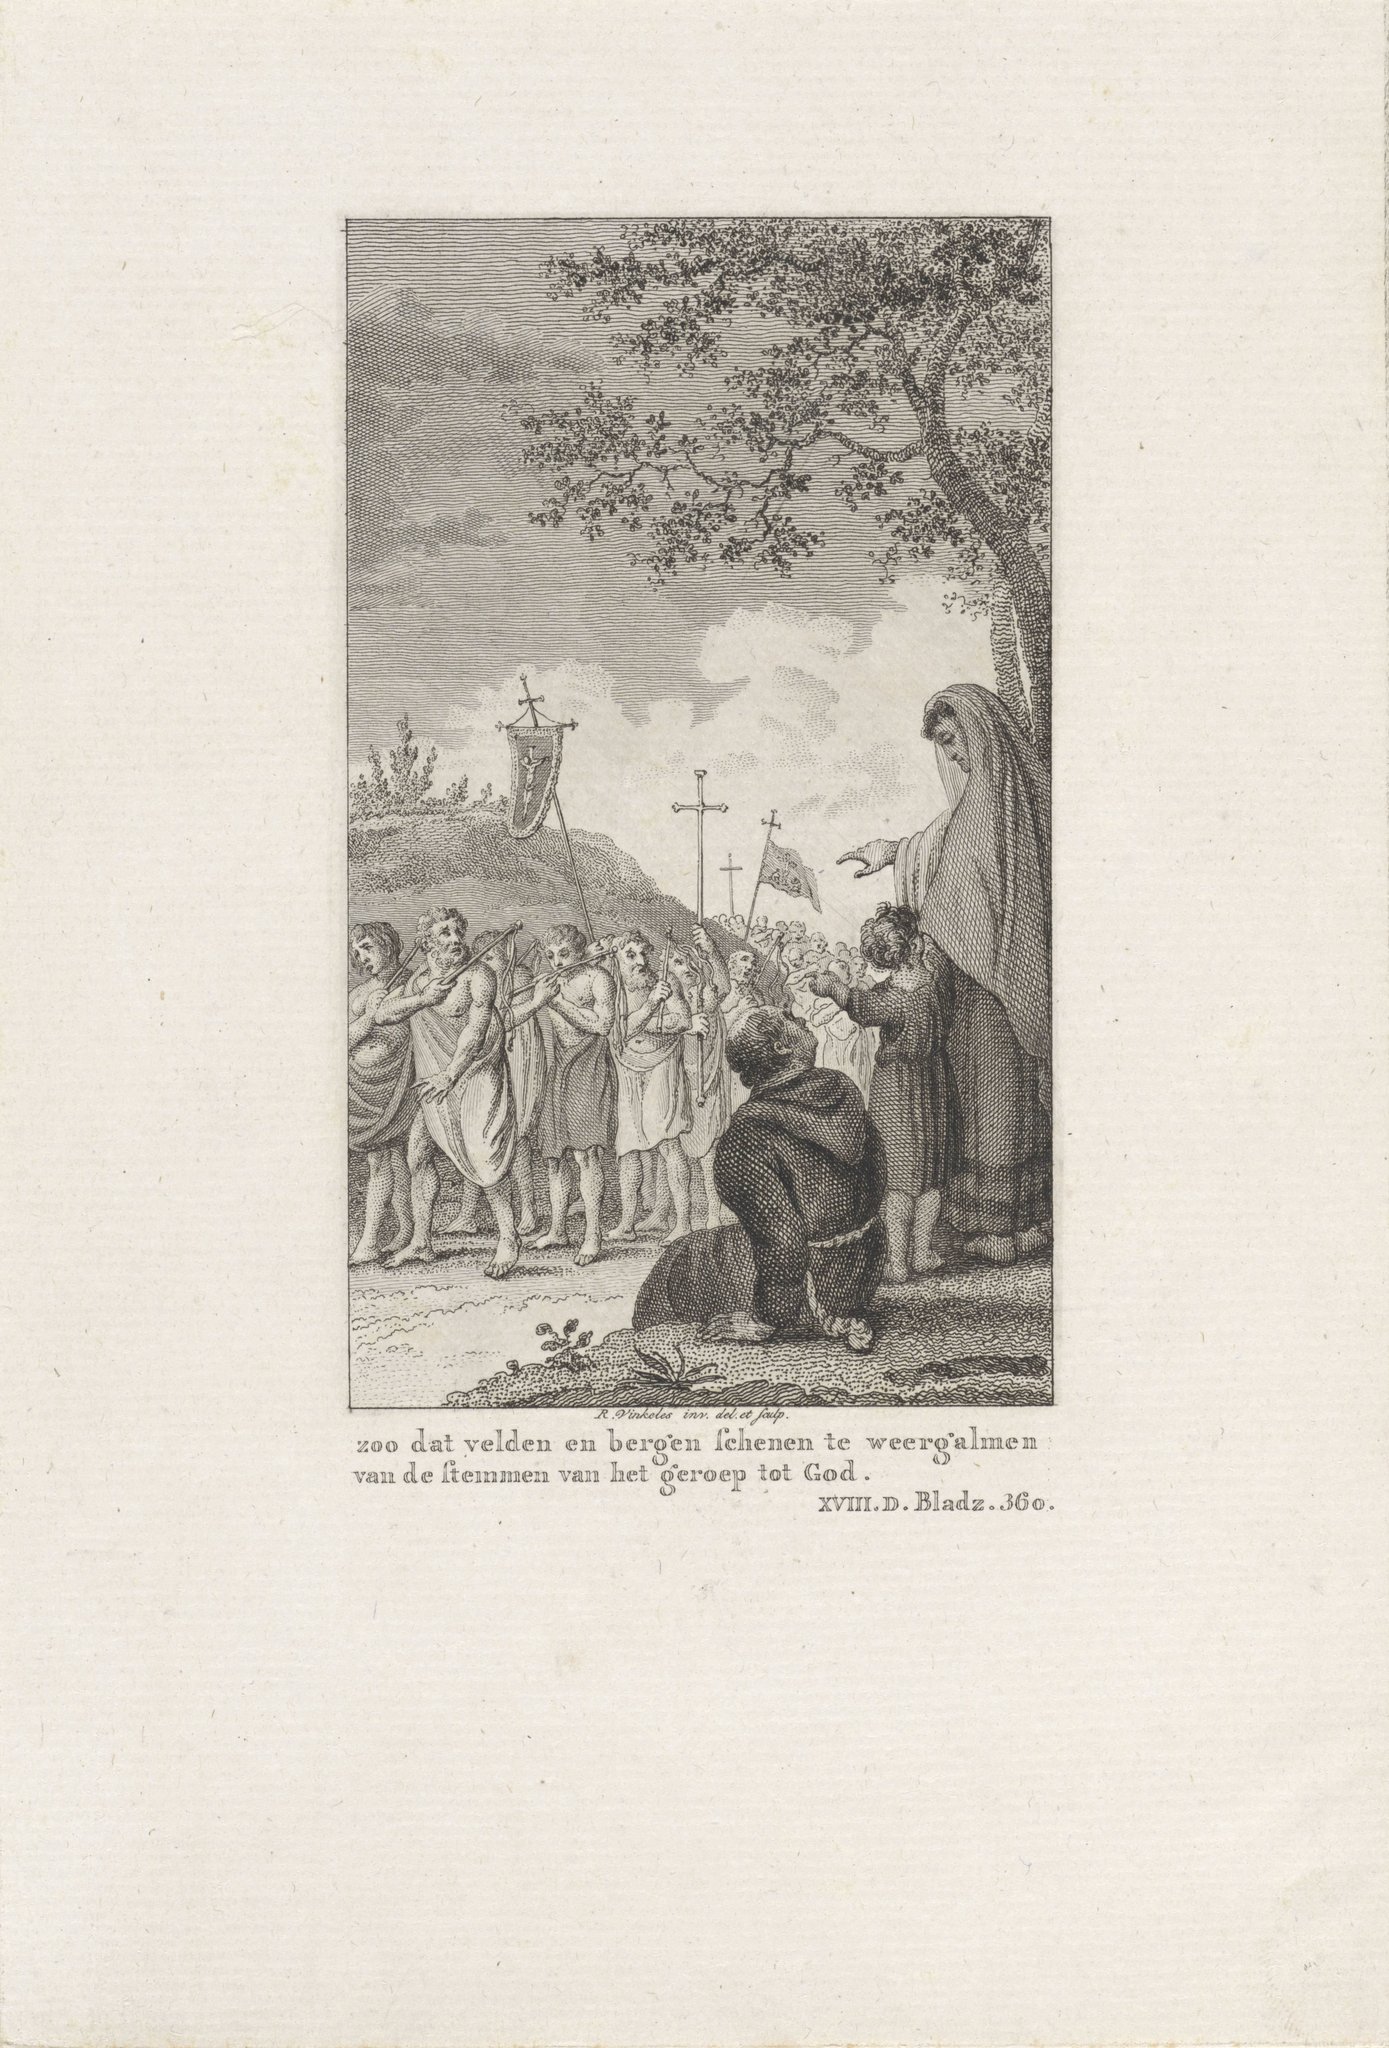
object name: book illustration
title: Processie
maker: reinier vinkeles (i)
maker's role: draughtsman, print maker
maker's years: 1741-1816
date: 1809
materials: paper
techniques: engraving, etching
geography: amsterdam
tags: landscapes, procession ~ christian religion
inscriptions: collector's mark: Lugt 2228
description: Deze prent is ook gebruikt als illustratie in: Hamelsveld, Ysbrand van. Algemeene kerkelijke geschiedenis, der Christenen, deel 18. Haarlem: François Bohn, 1809, p. 306.